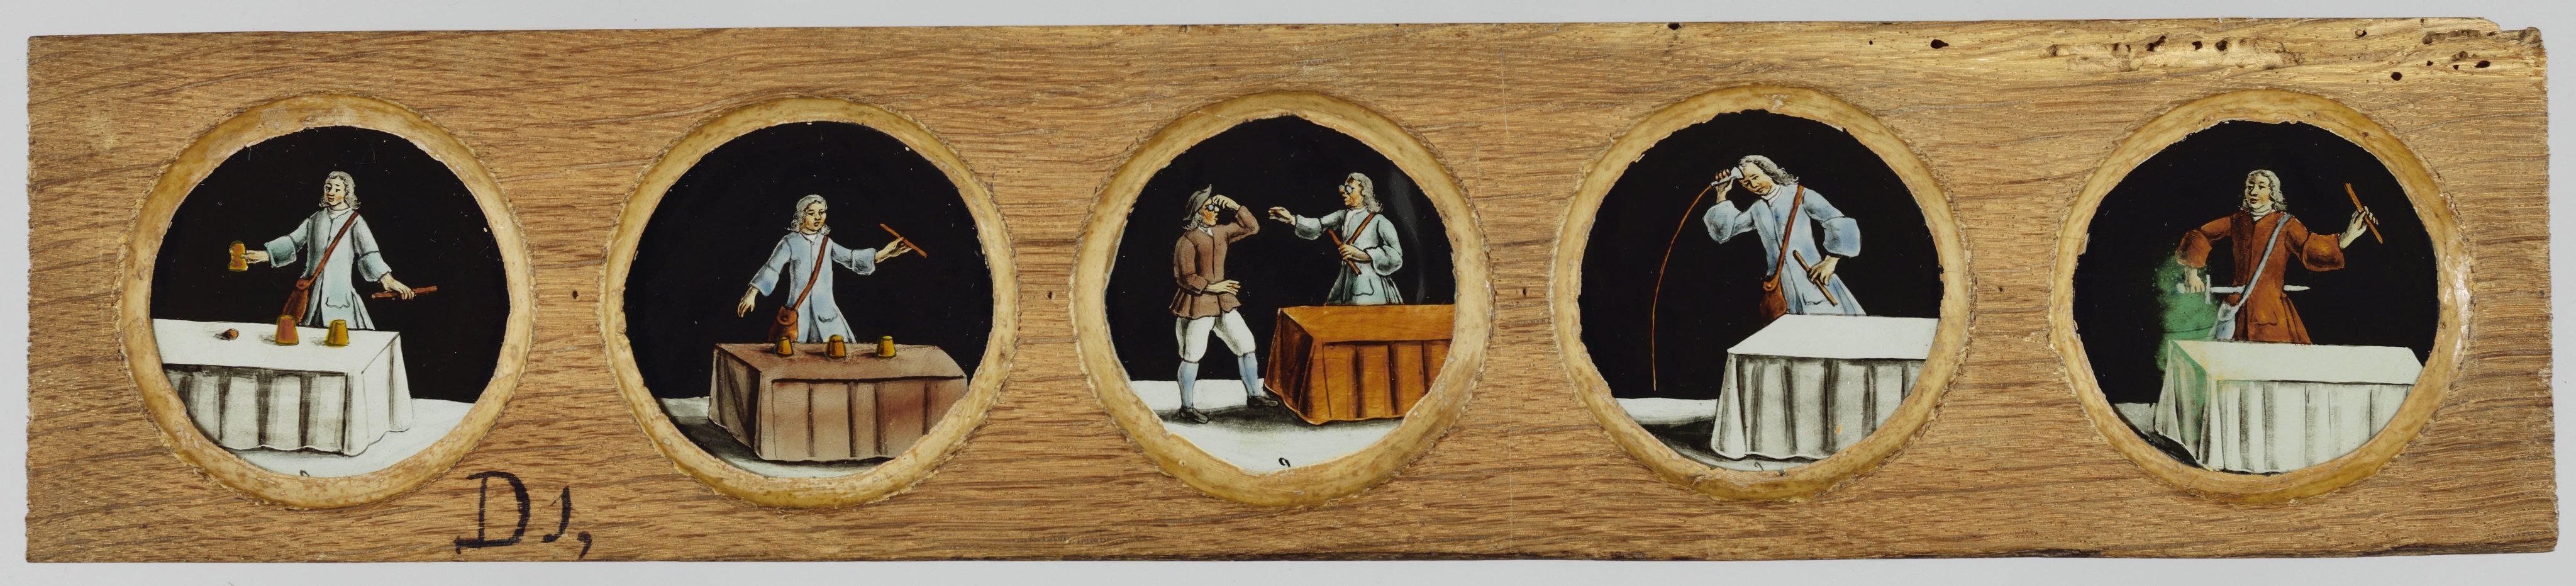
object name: lantern slide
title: Vijf afbeeldingen van goocheltruuks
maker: Anonymous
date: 1700-1790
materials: glass, wood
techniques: painted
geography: netherlands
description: Afgebeeld is telkens een man met een tas en een stokje. links = een man staat achter een tafel en speelt een spelletje met drie bekertjes, waaronder een balletje moet liggen. De man houdt in zijn hand de linkerbeker vast, daaronder ligt het balletje. Daarnaast liggen nog twee bekertje omgekeerd op tafel. De man heeft een tas om zijn schouder. 2e van links = een man staat voor een tafel. Op de tafel liggen drie bekertjes op de kop. Hij heeft een tas om en een stokje in zijn hand. midden = twee mannen. De ene staat achter een tafel, de ander staat naast de tafel. Beide dragen een zonnebril en kijken naar elkaar. 2e van rechts = een man achter een tafel heeft in zijn linkerhand een soort toeter dat hij voor zijn hoofd houdt. Hij heeft een tas om en een stokje in zijn andere hand. rechts = een man steekt een zwaard door zich heen. Hij draagt een stokje in zijn hand en heeft een tas om.